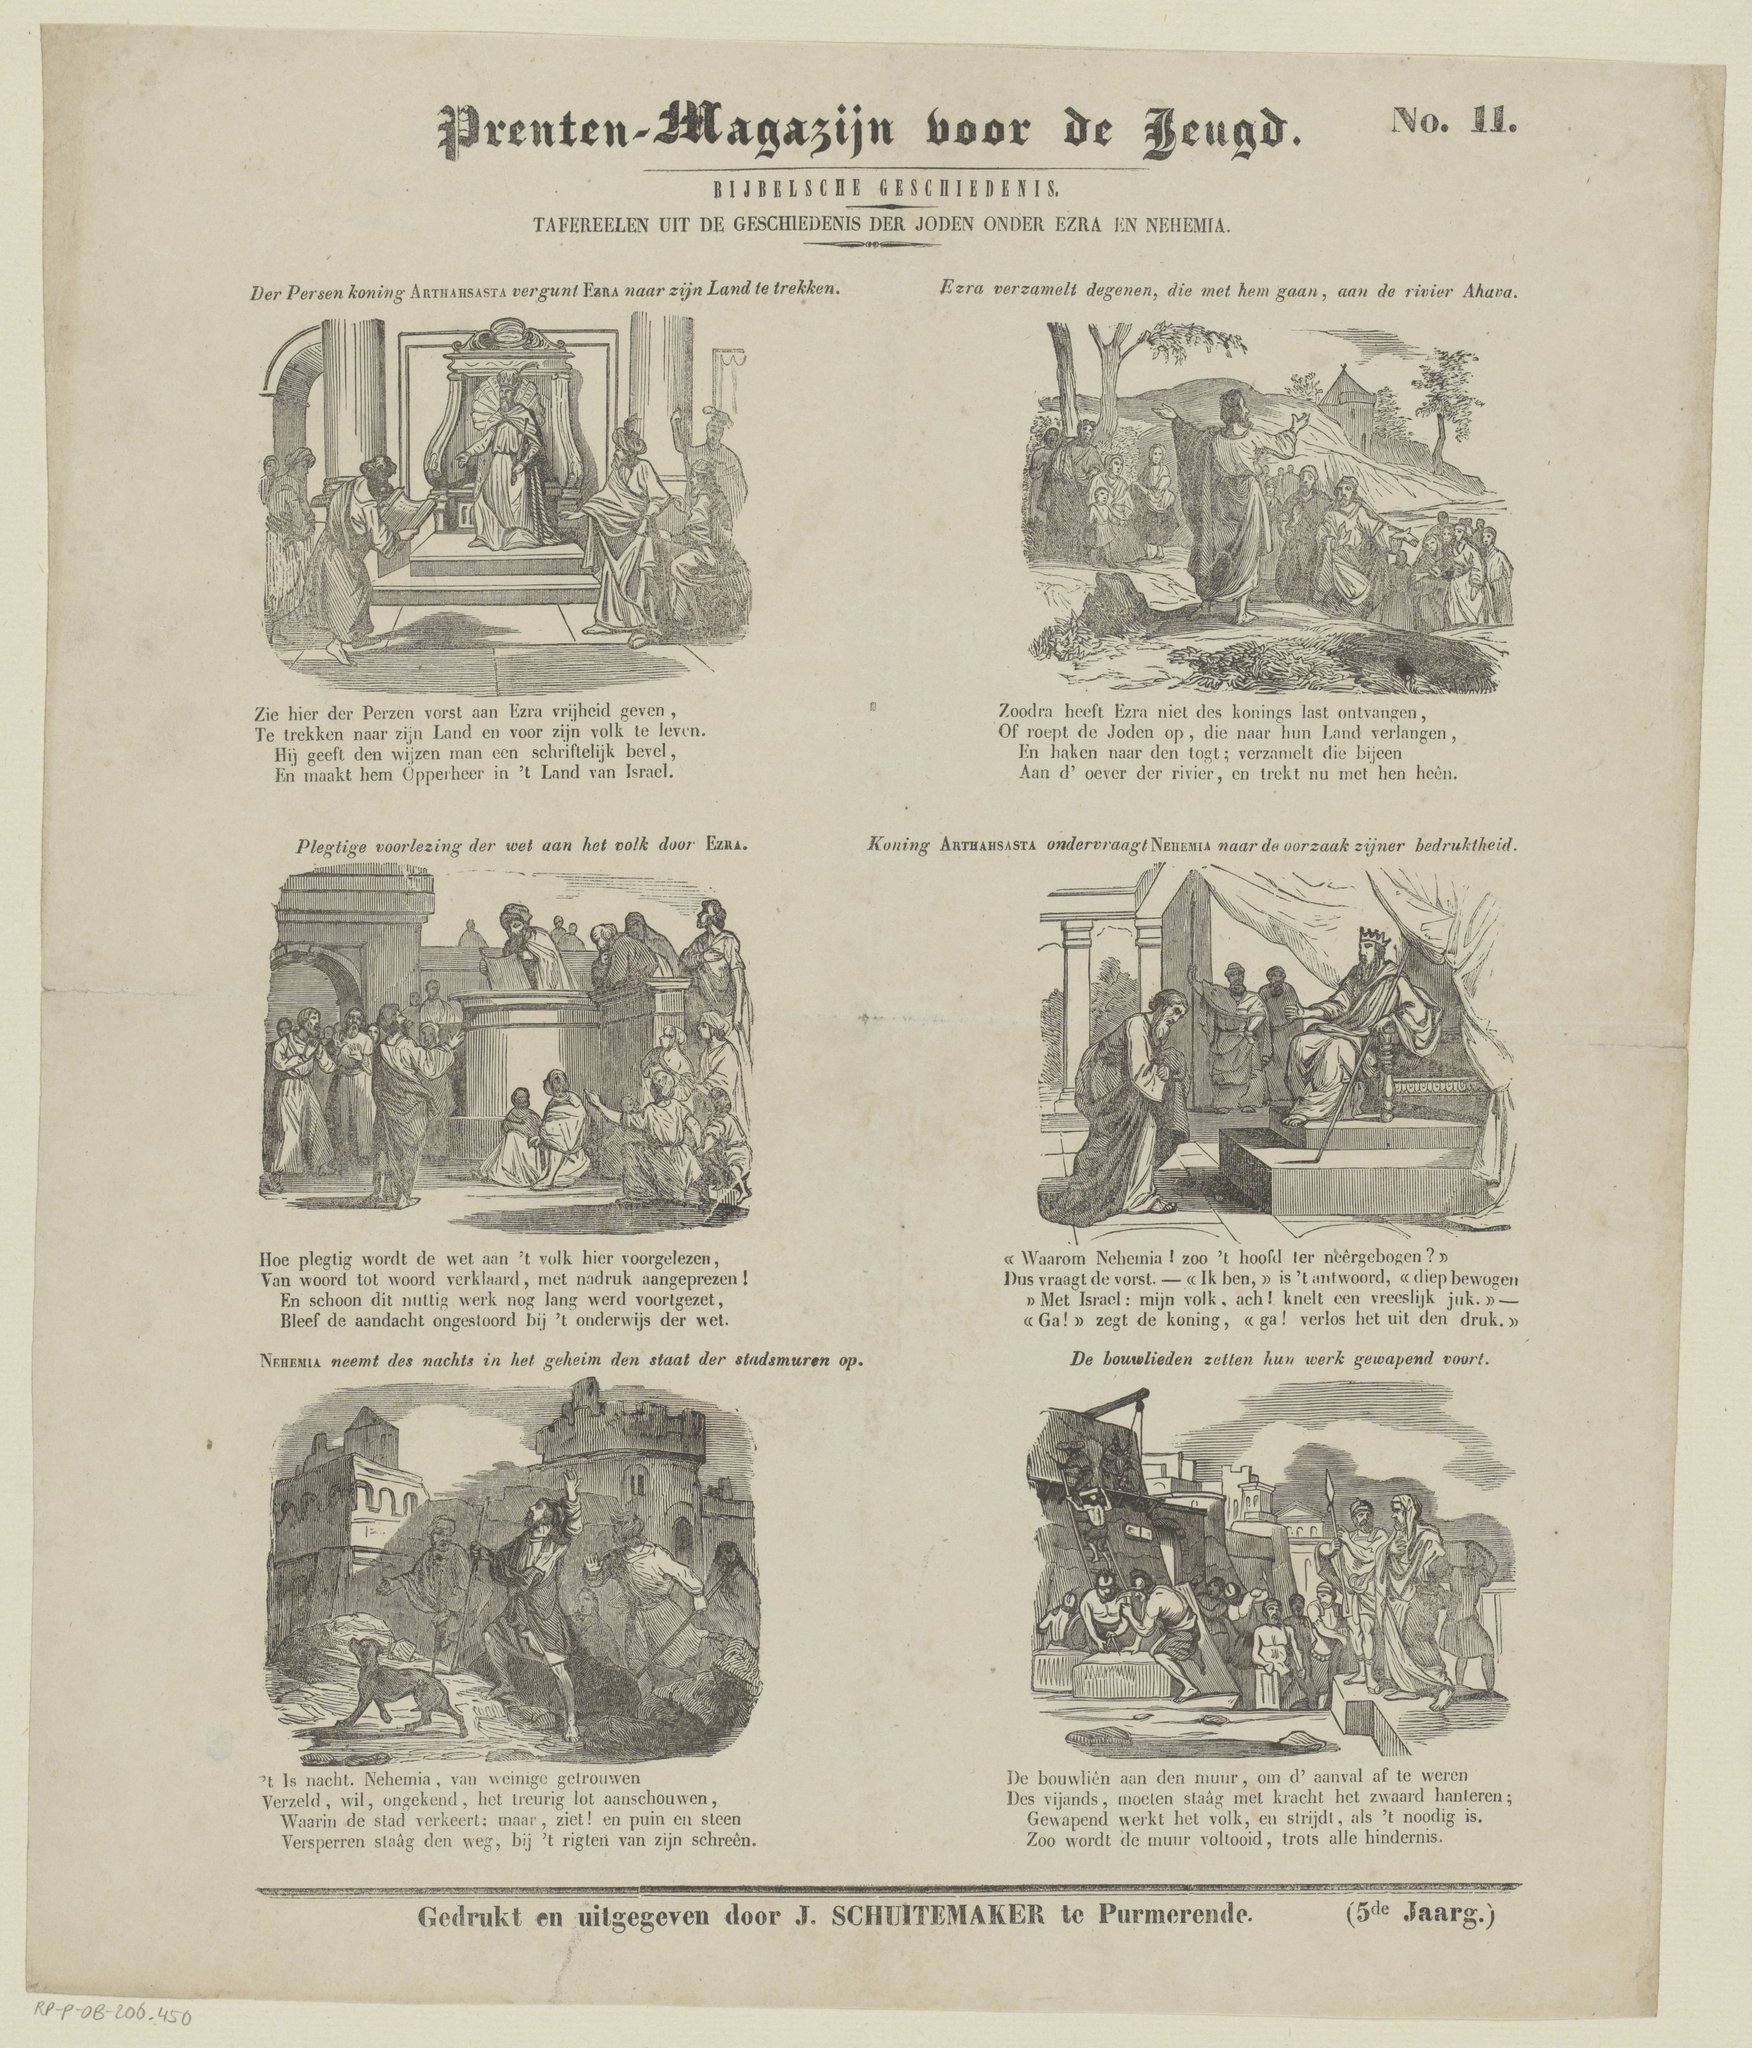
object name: print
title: Prenten-magazijn voor de jeugd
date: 1846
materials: paper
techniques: letterpress printing, engraving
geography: purmerend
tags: the books of ezra, nehemiah, and esdras, the return of ezra (ezra 7-8), old testament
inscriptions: collector's mark: Lugt 2760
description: Blad met 6 voorstellingen van verhalen uit het Oude Testament. Boven elke afbeelding een titel, onder elke afbeelding een vierregelig vers. Genummerd rechtsboven: No. 11.